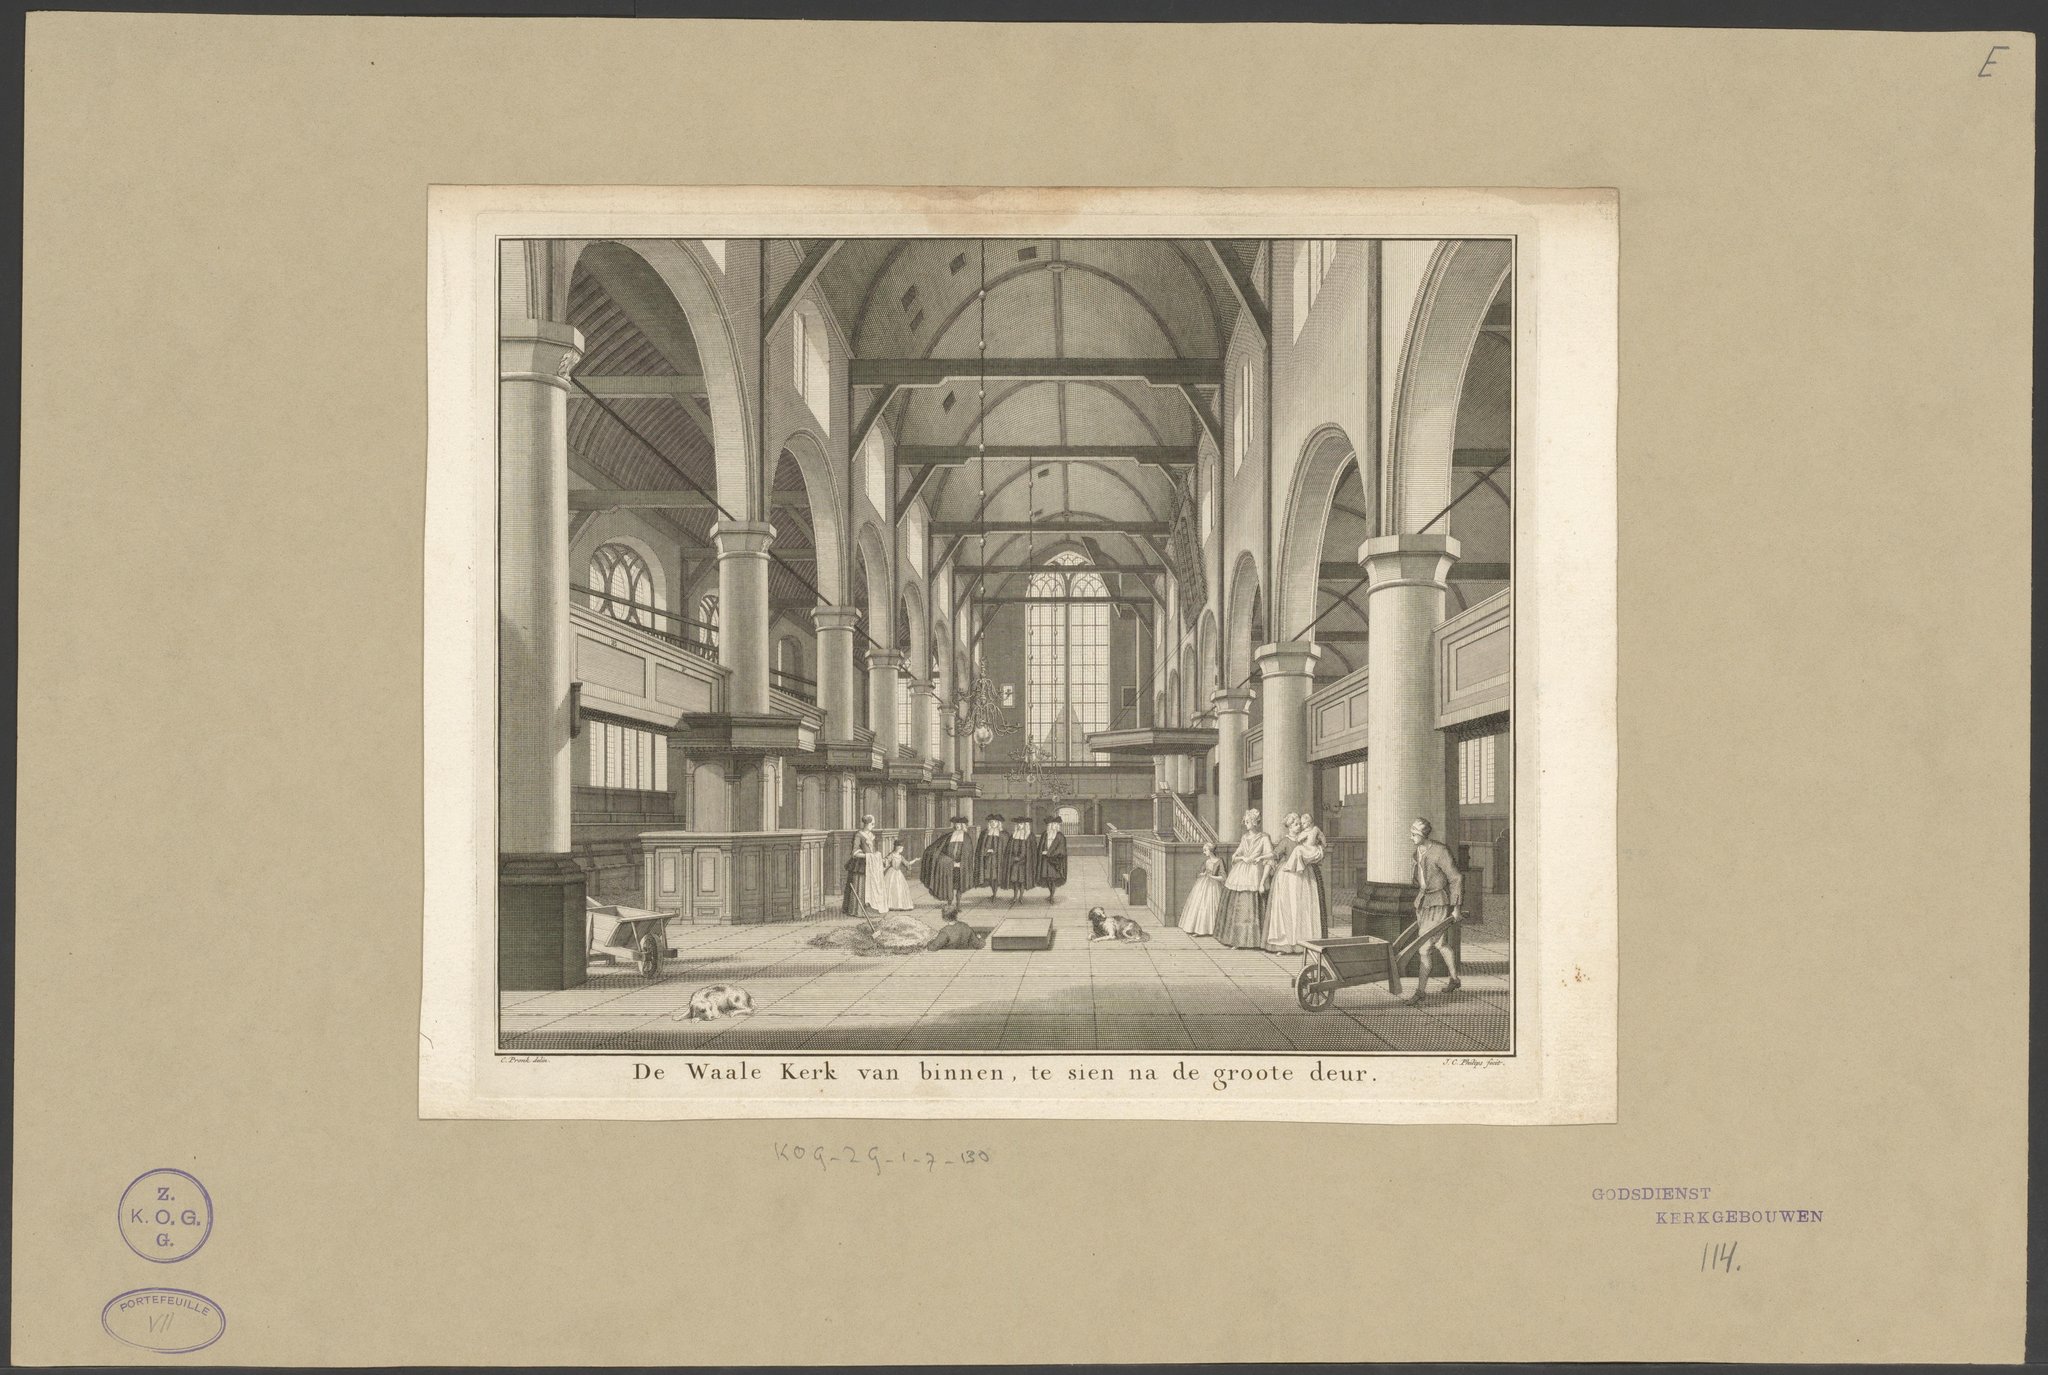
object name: print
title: Interieur van de Waalse Kerk te Amsterdam, gezien richting de hoofdingang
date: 1730-1759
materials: paper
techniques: engraving, etching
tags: church (exterior), grave, tomb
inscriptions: stamp, collector's mark: Lugt 1641, stamp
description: Interieur van de Waalse Kerk gezien vanaf het orgel. In het midden graaft een man een graf. Onderwerpsrubrieken binnen de Atlas Zeden en Gewoonten: Godsdienst, Kerkgebouwen te Amsterdam.